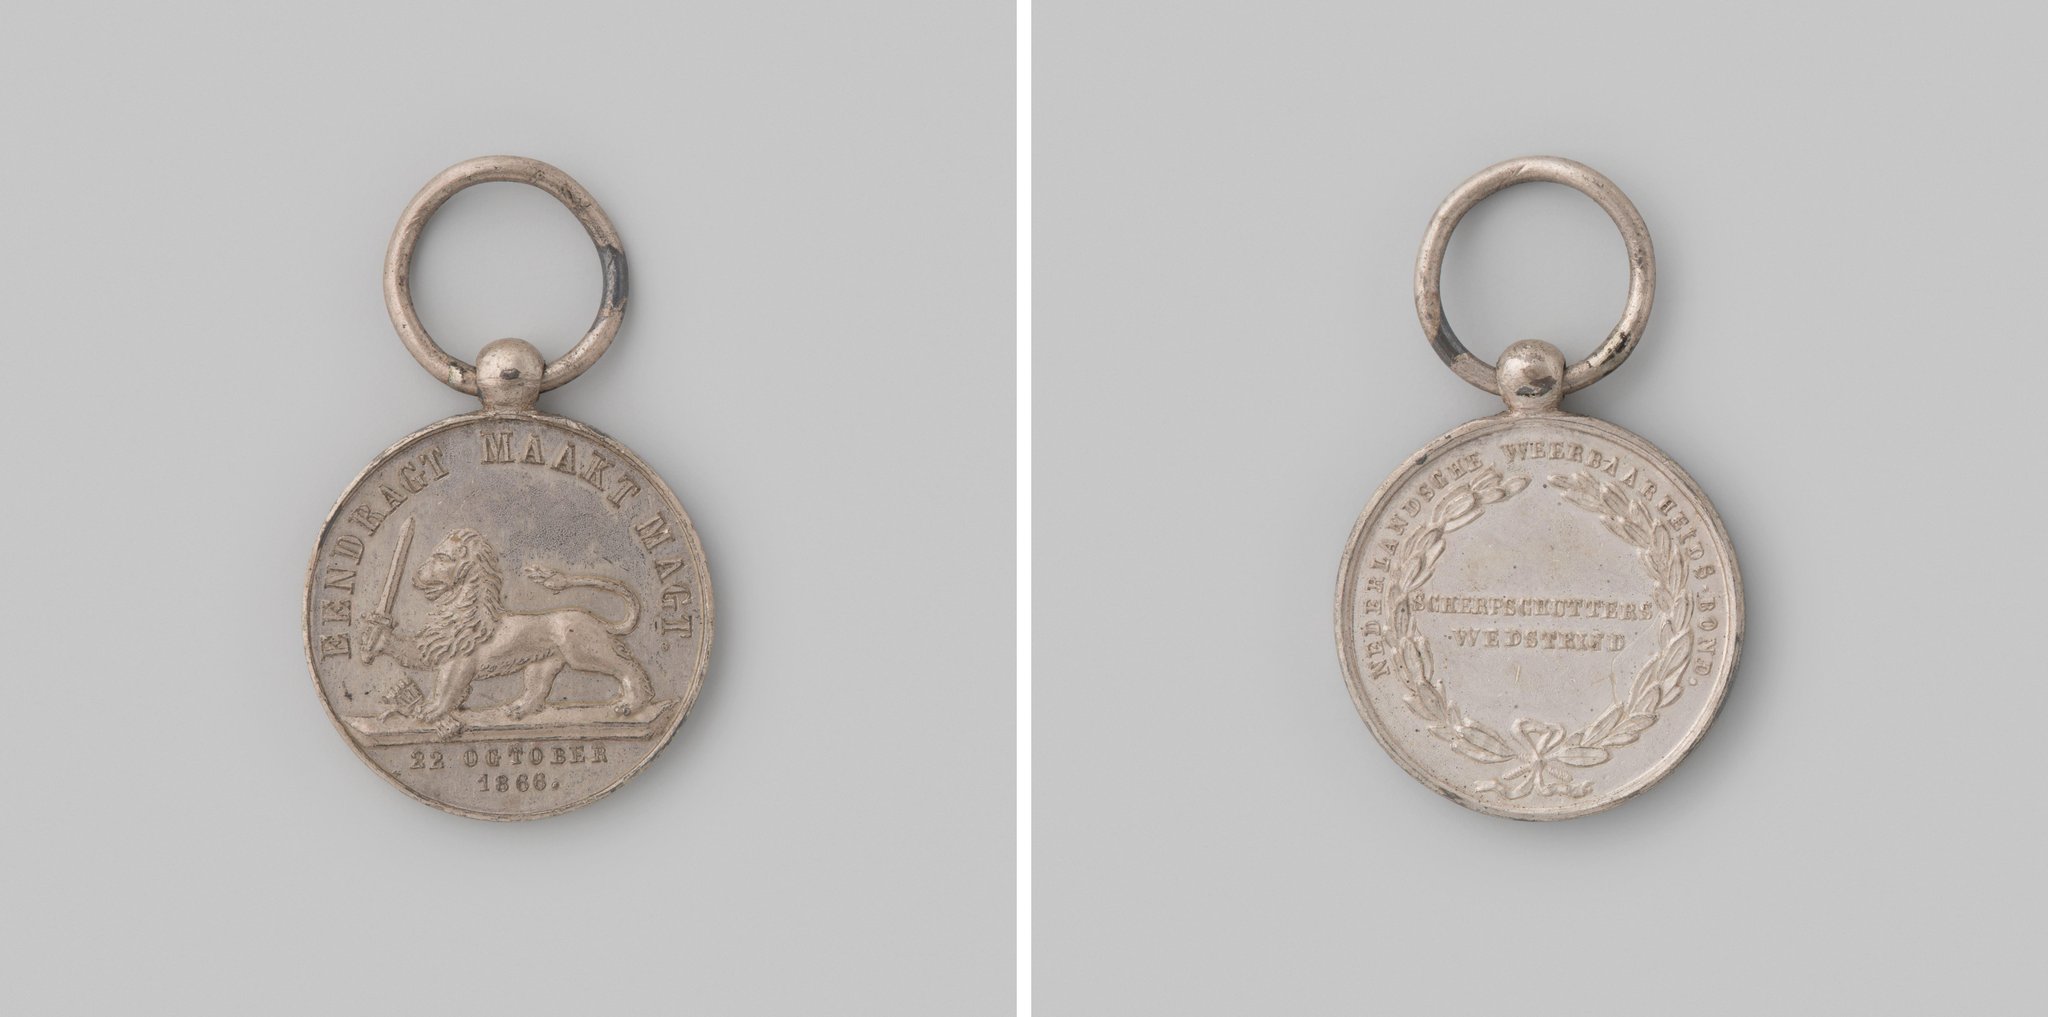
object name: honorary medal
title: Herinneringspenning aan de vierde nationale schietwedstrijd te Waalsdorp, uitgeschreven door de Nederlandsche Weerbaarheidsbond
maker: Anonymous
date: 1873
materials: silver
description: Zilveren penning met knop en ring. Voorzijde: gaande leeuw met een zwaard in de rechter klauw, de linker klauw rust op een bundel pijlen. Omschrift: EENDRAGT MAAKT MAGT. Afsnede: 22 october / 1866. Keerzijde: in het veld binnen een lauwerkrans SCHERPSCHUTTERS / WEDSTRIJD. Omschrift: NEDERLANDSCHE WEERBAARHEIDS-BOND.